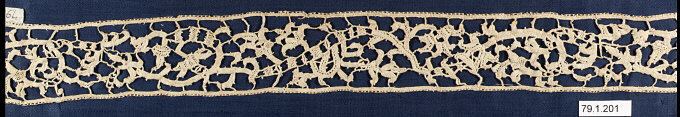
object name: strip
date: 1601-1633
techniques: lace